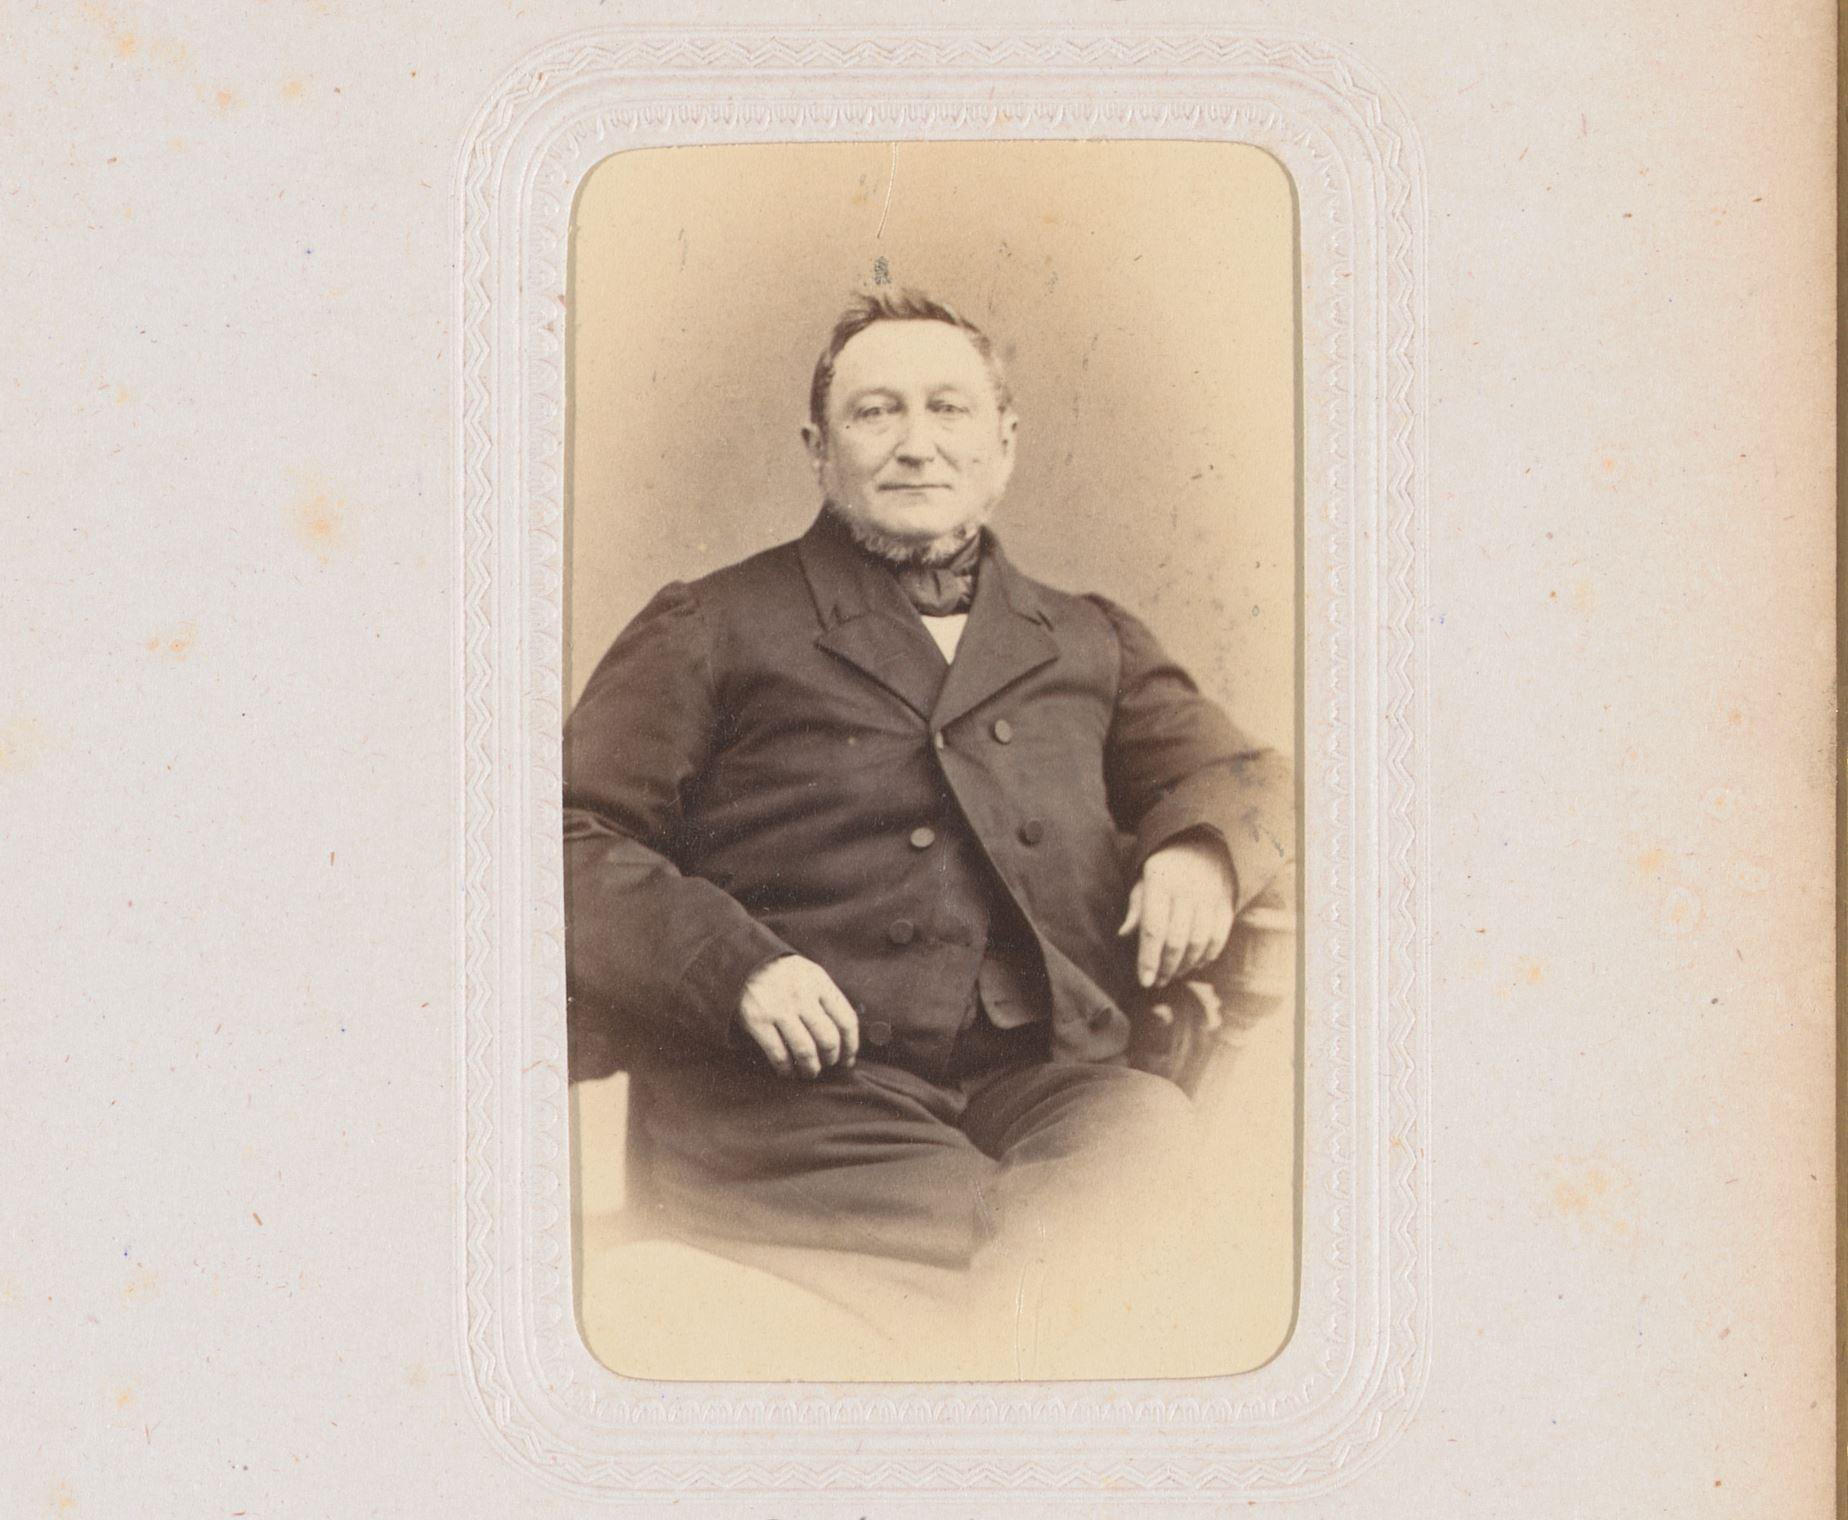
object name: photograph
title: Portret van een zittende man, aangeduid als Schot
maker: maurits verveer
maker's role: painter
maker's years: 1817-1903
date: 1855-1870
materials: cardboard, photographic support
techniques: albumen print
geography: the hague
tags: sitting figure, historical persons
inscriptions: name: ‘[.] Schot.’, inscription: ‘M. VERVEER/ PHOTOGRAPHE/ de L.L.M.M. le Roi et la Reine des Pays-Bas/ 52, ZEESTRAAT 52./ VIS A VIS DU WILLEMSPARK/ LA HAYE’, name: ‘Schot’